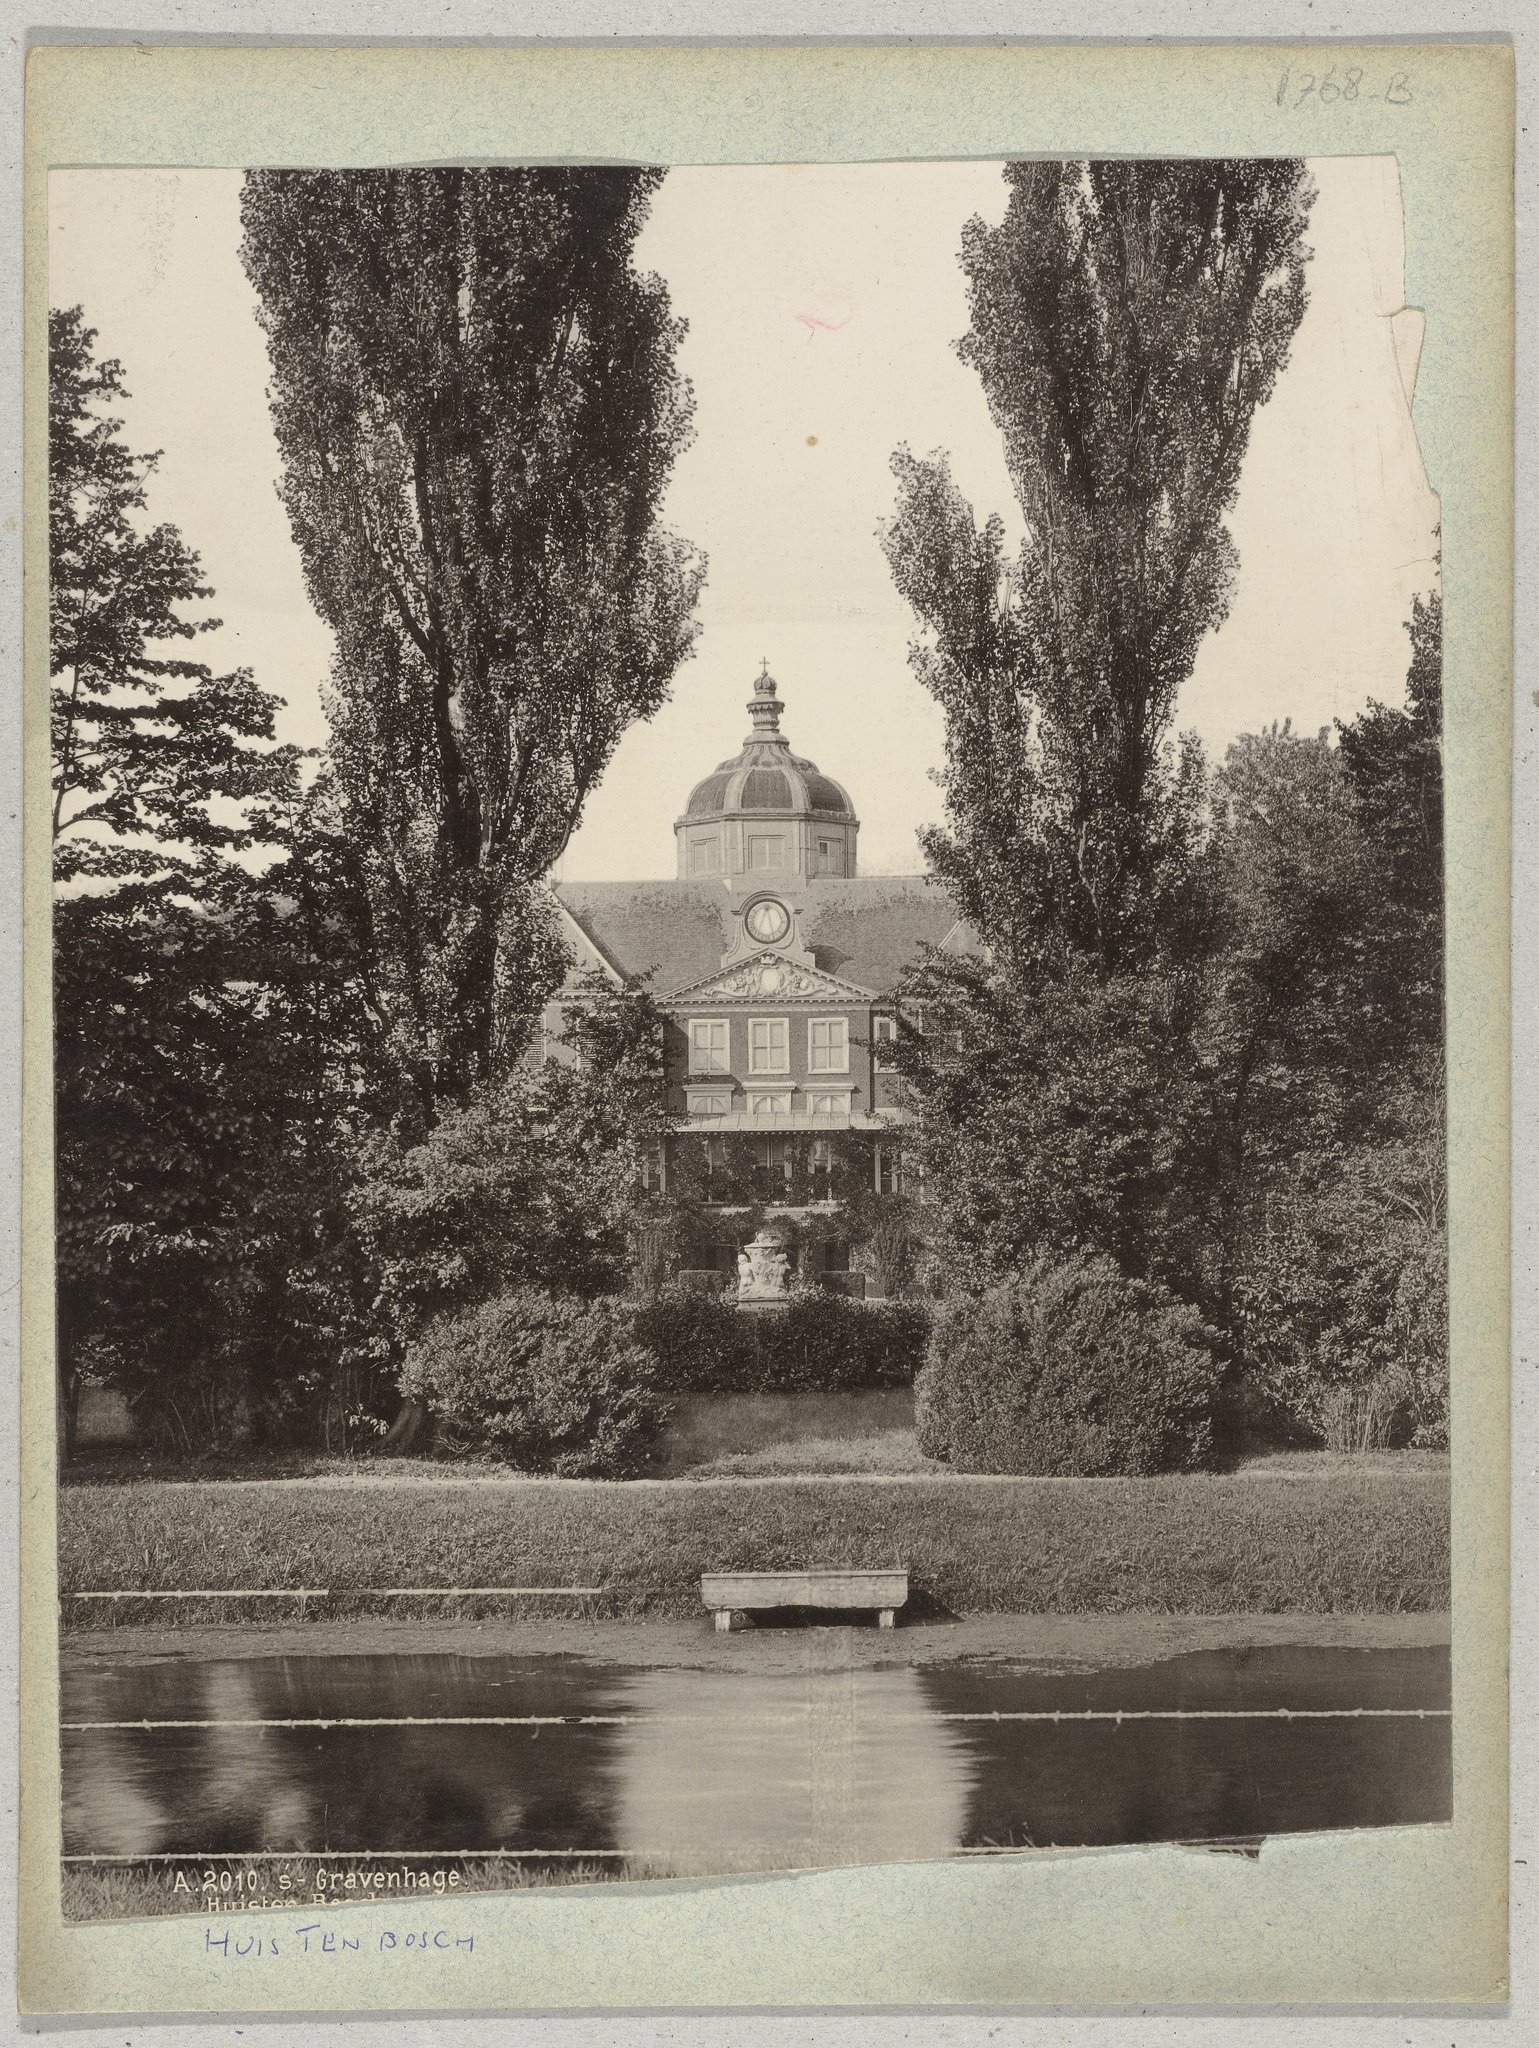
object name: photograph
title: Gezicht op Huis ten Bosch in Den Haag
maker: Anonymous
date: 1880-1920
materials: paper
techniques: photograph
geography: netherlands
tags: palace